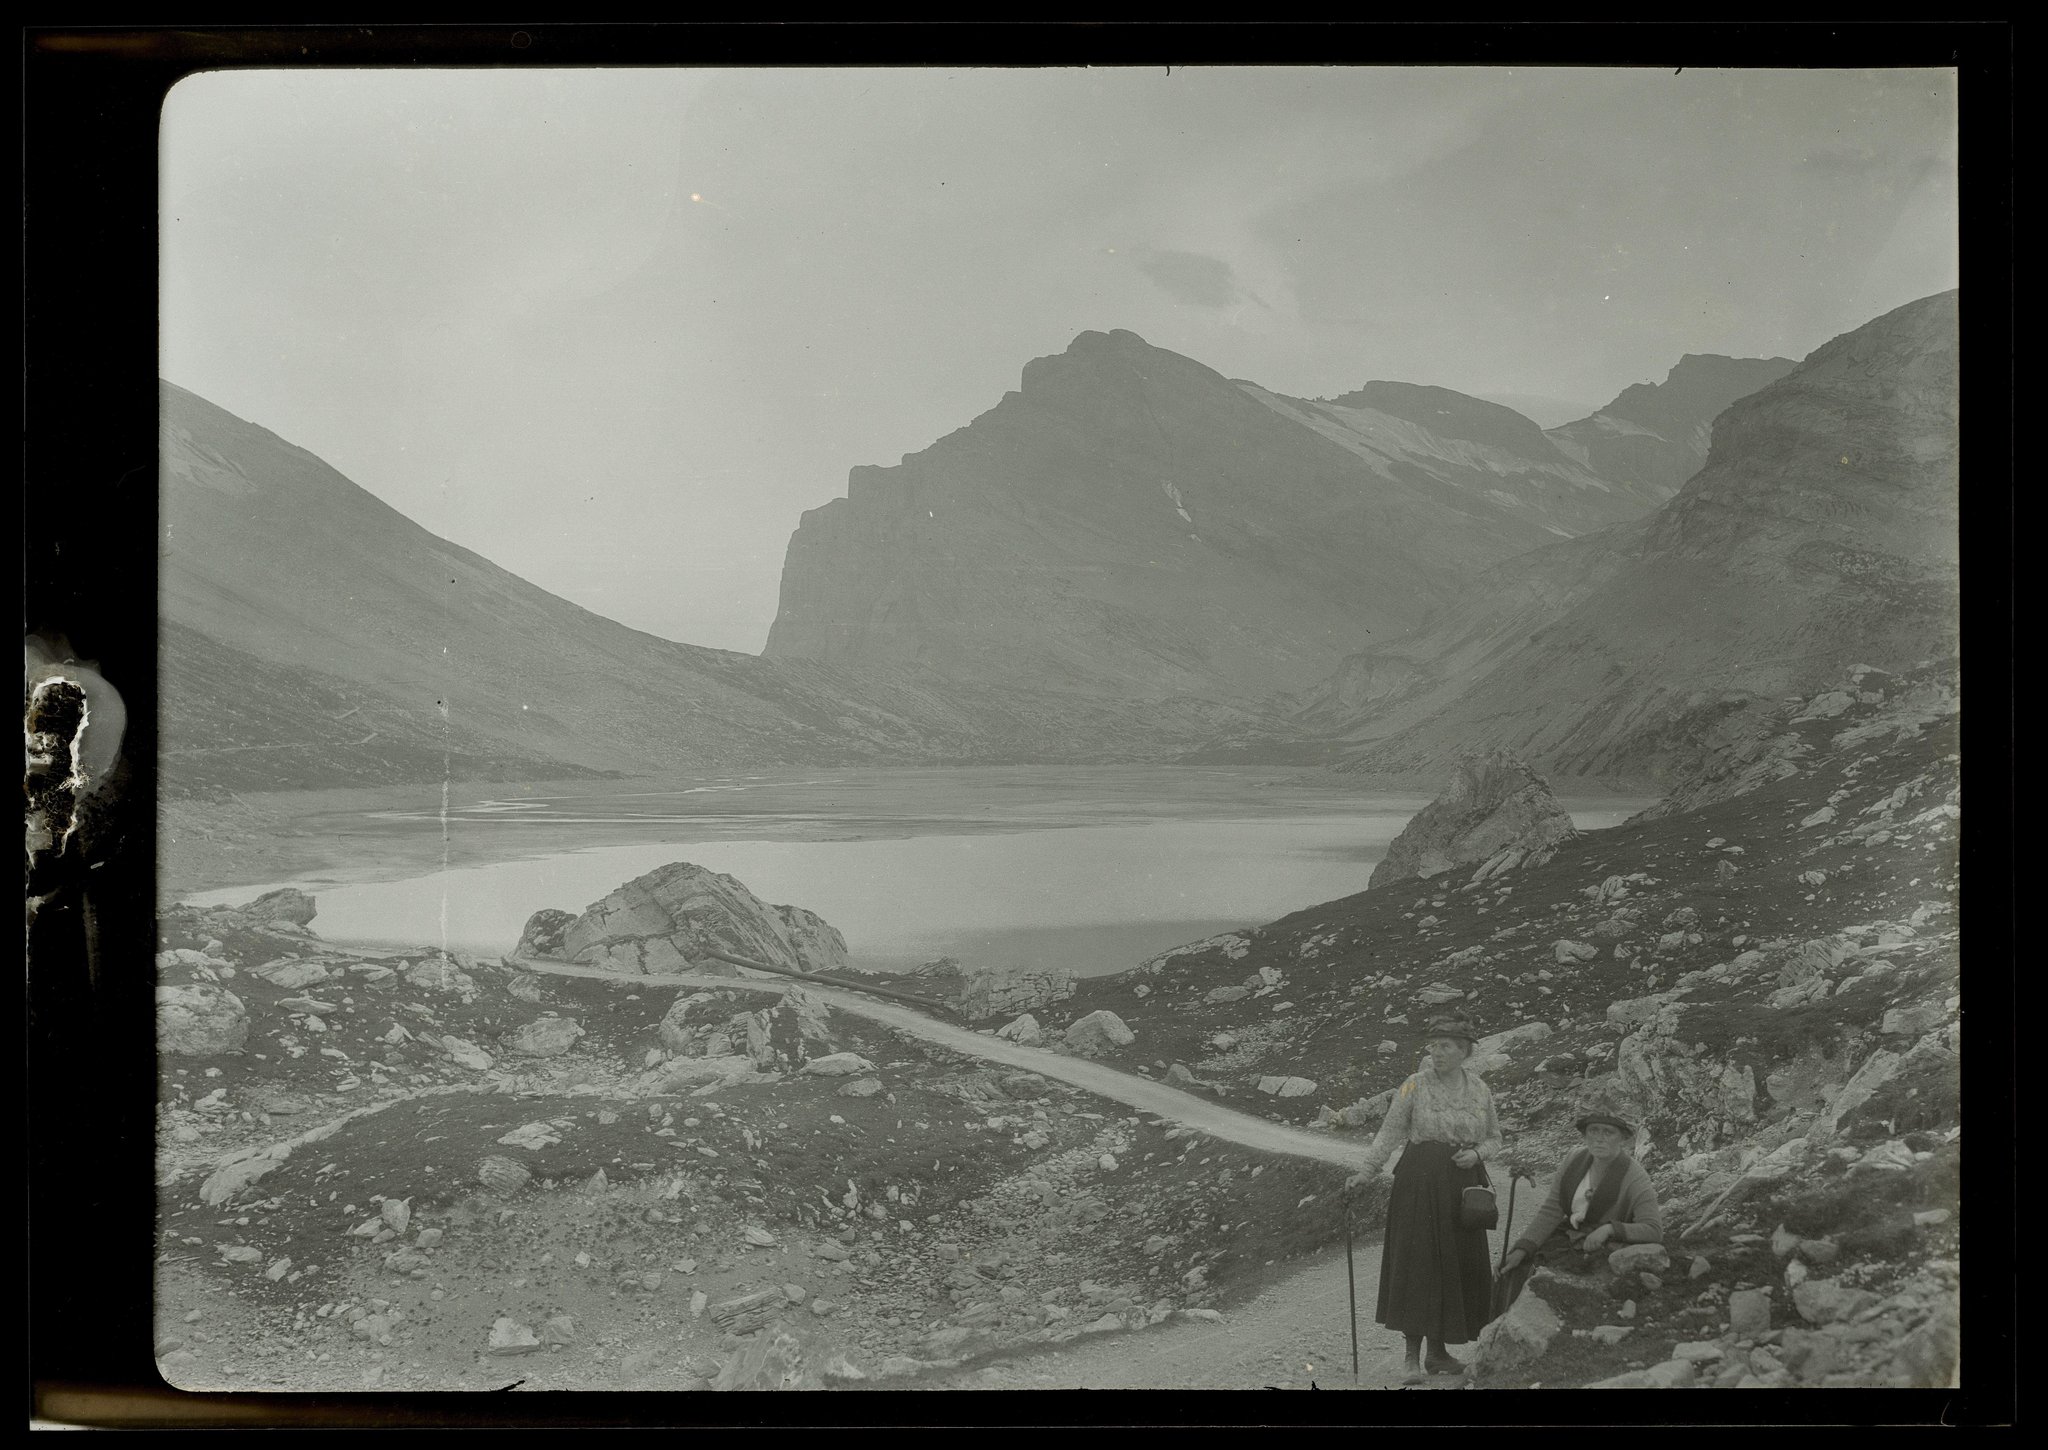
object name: negative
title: Filmnegatief met opname van Basel, Thun, Kandersteg of Gemmi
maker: Anonymous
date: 1921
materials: film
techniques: gelatin silver negative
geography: switzerland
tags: switzerland